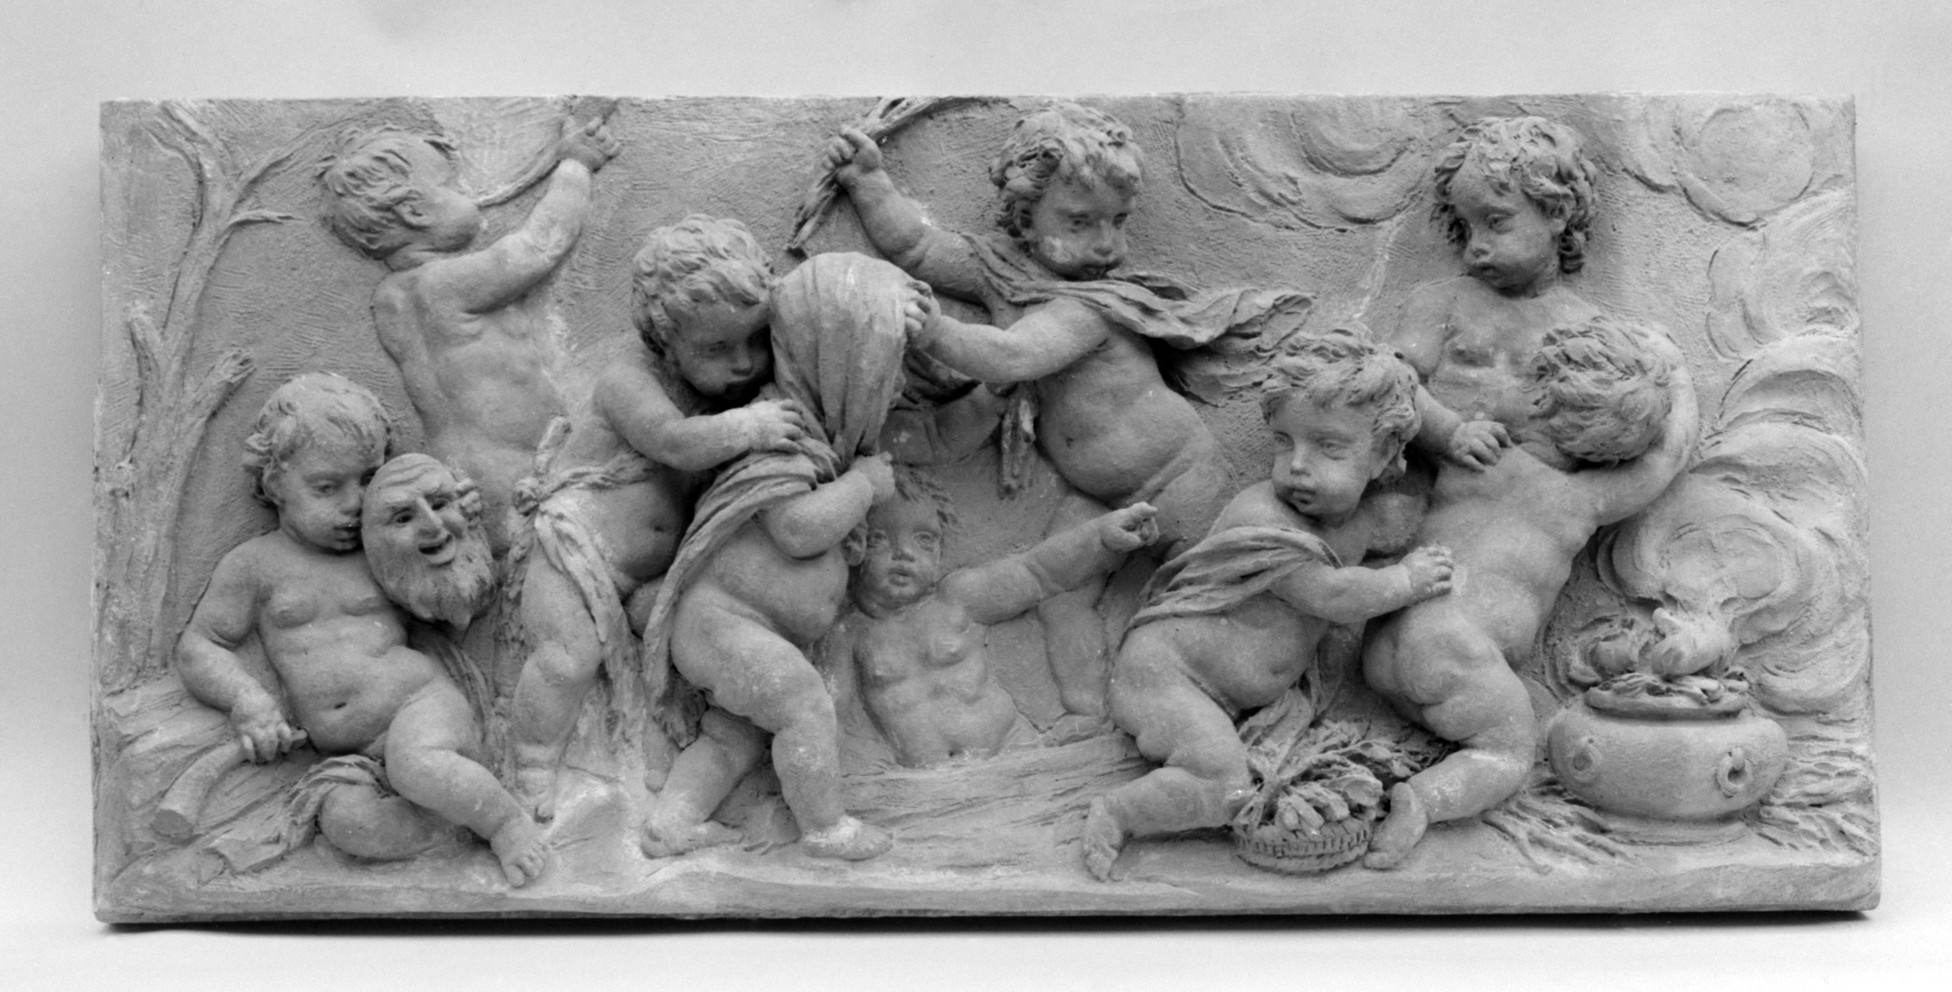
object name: plaque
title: Winter (one of a pair)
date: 1701-1800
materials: terracotta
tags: putti,winter